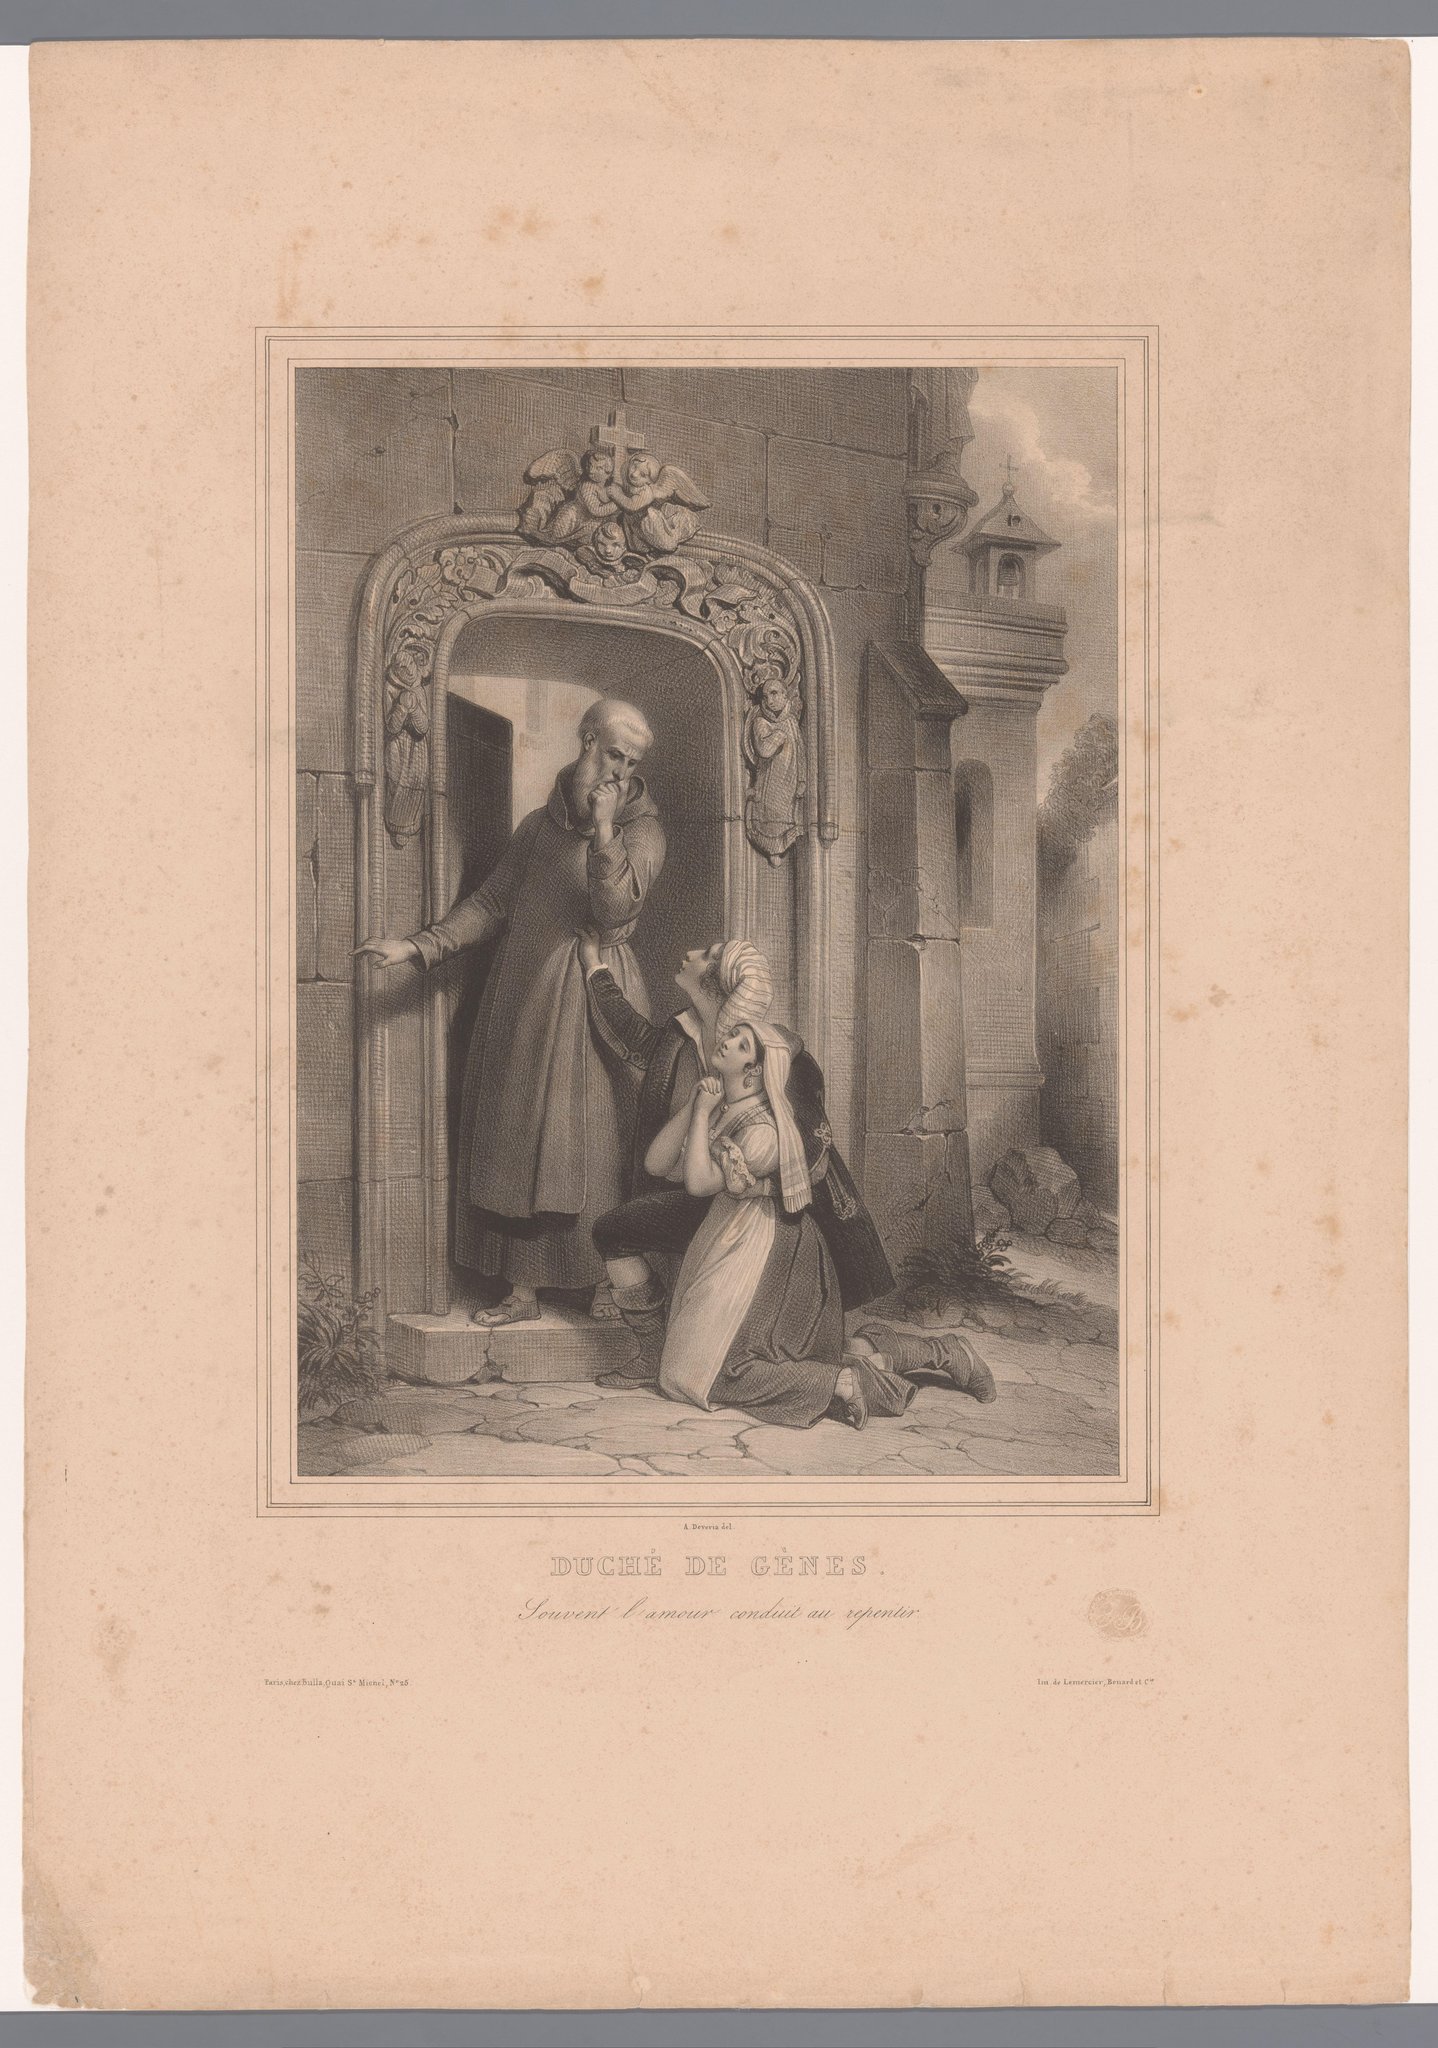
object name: print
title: Duché de Gènes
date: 1834-1838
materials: paper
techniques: lithograph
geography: paris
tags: roman catholic church, human races; peoples; nationalities, couple of lovers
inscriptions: check stamp: Lugt 4088